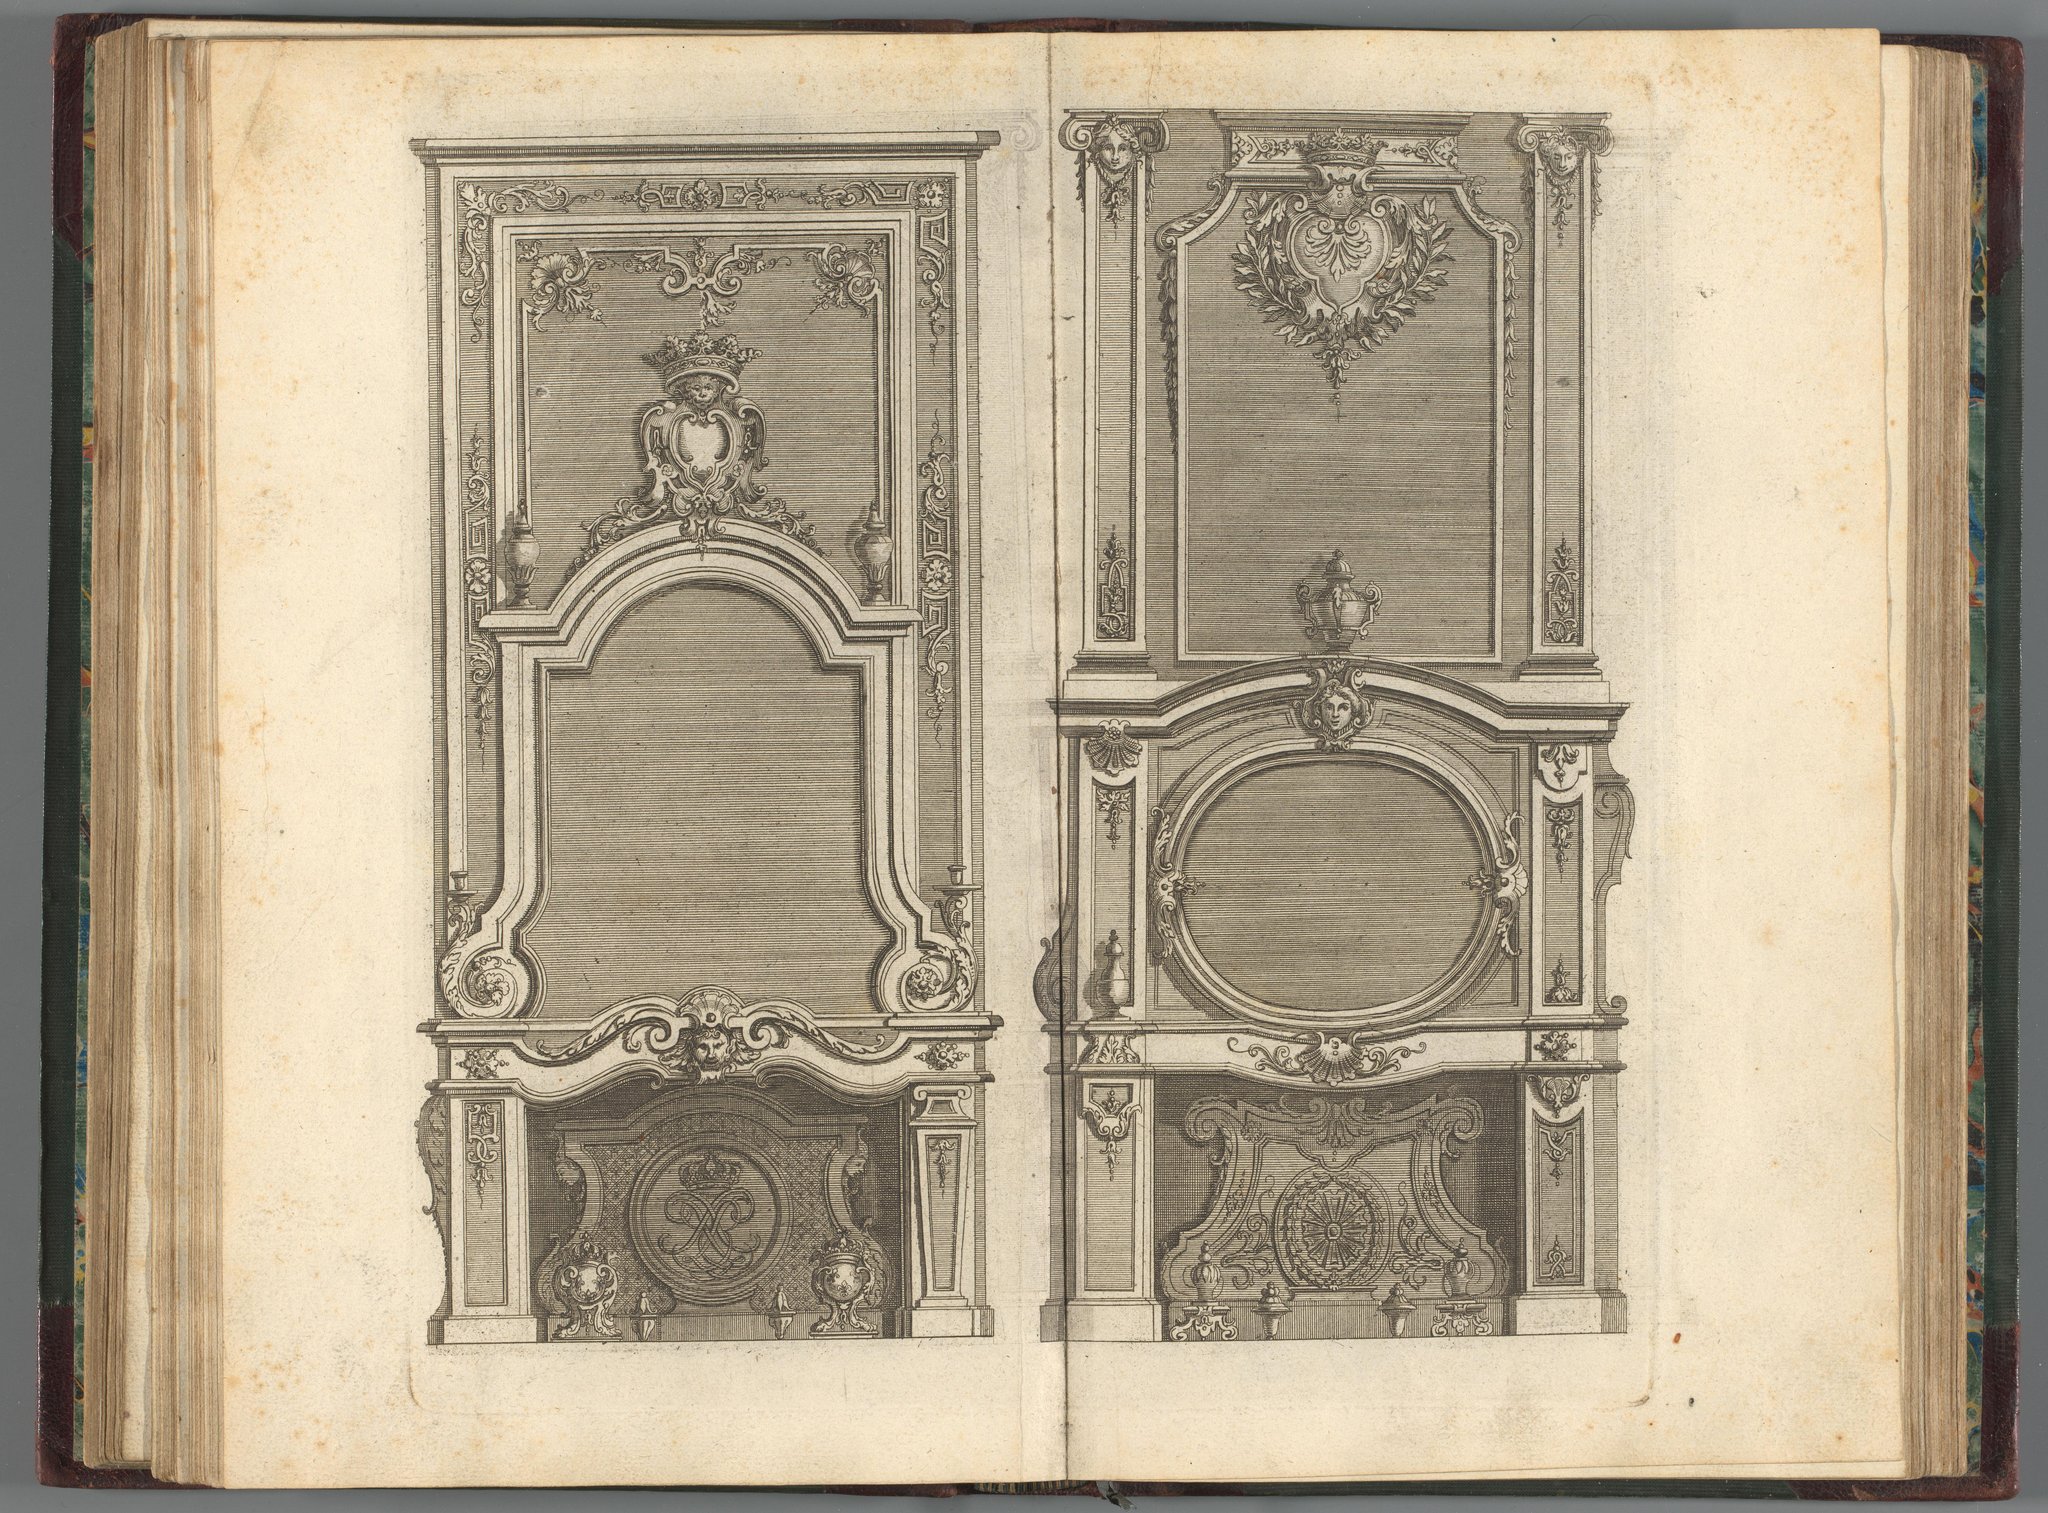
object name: ornament print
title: Haarden met cartouche en vazen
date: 1686-1724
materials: paper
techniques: etching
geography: augsburg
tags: ornaments ~ art, fire-screen, vase ~ ornament, open hearth, fire-place, ornament ~ cartouche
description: Twee geornamenteerde haarden. Links met een gekroond cartouche, twee vazen, twee kandelaars en een haardplaat met gekroonde initialen en globes met fleur-de-lis. Rechts met ionische pilasters, maskers, vazen, een ovaal medaillon en een haardplaat met rozet. Prent maakt deel uit van een album. Hoogstwaarschijnlijk gespiegelde kopie naar Frans origineel.